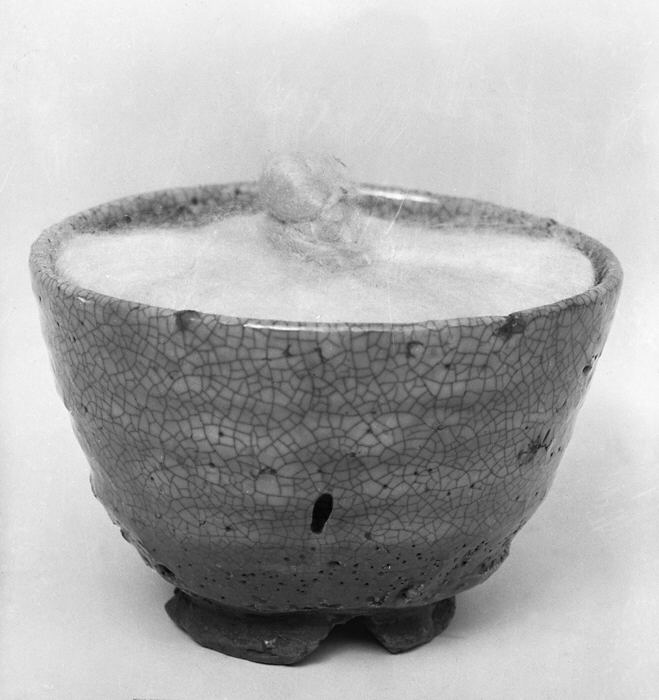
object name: teabowl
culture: japanese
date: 1725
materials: pottery